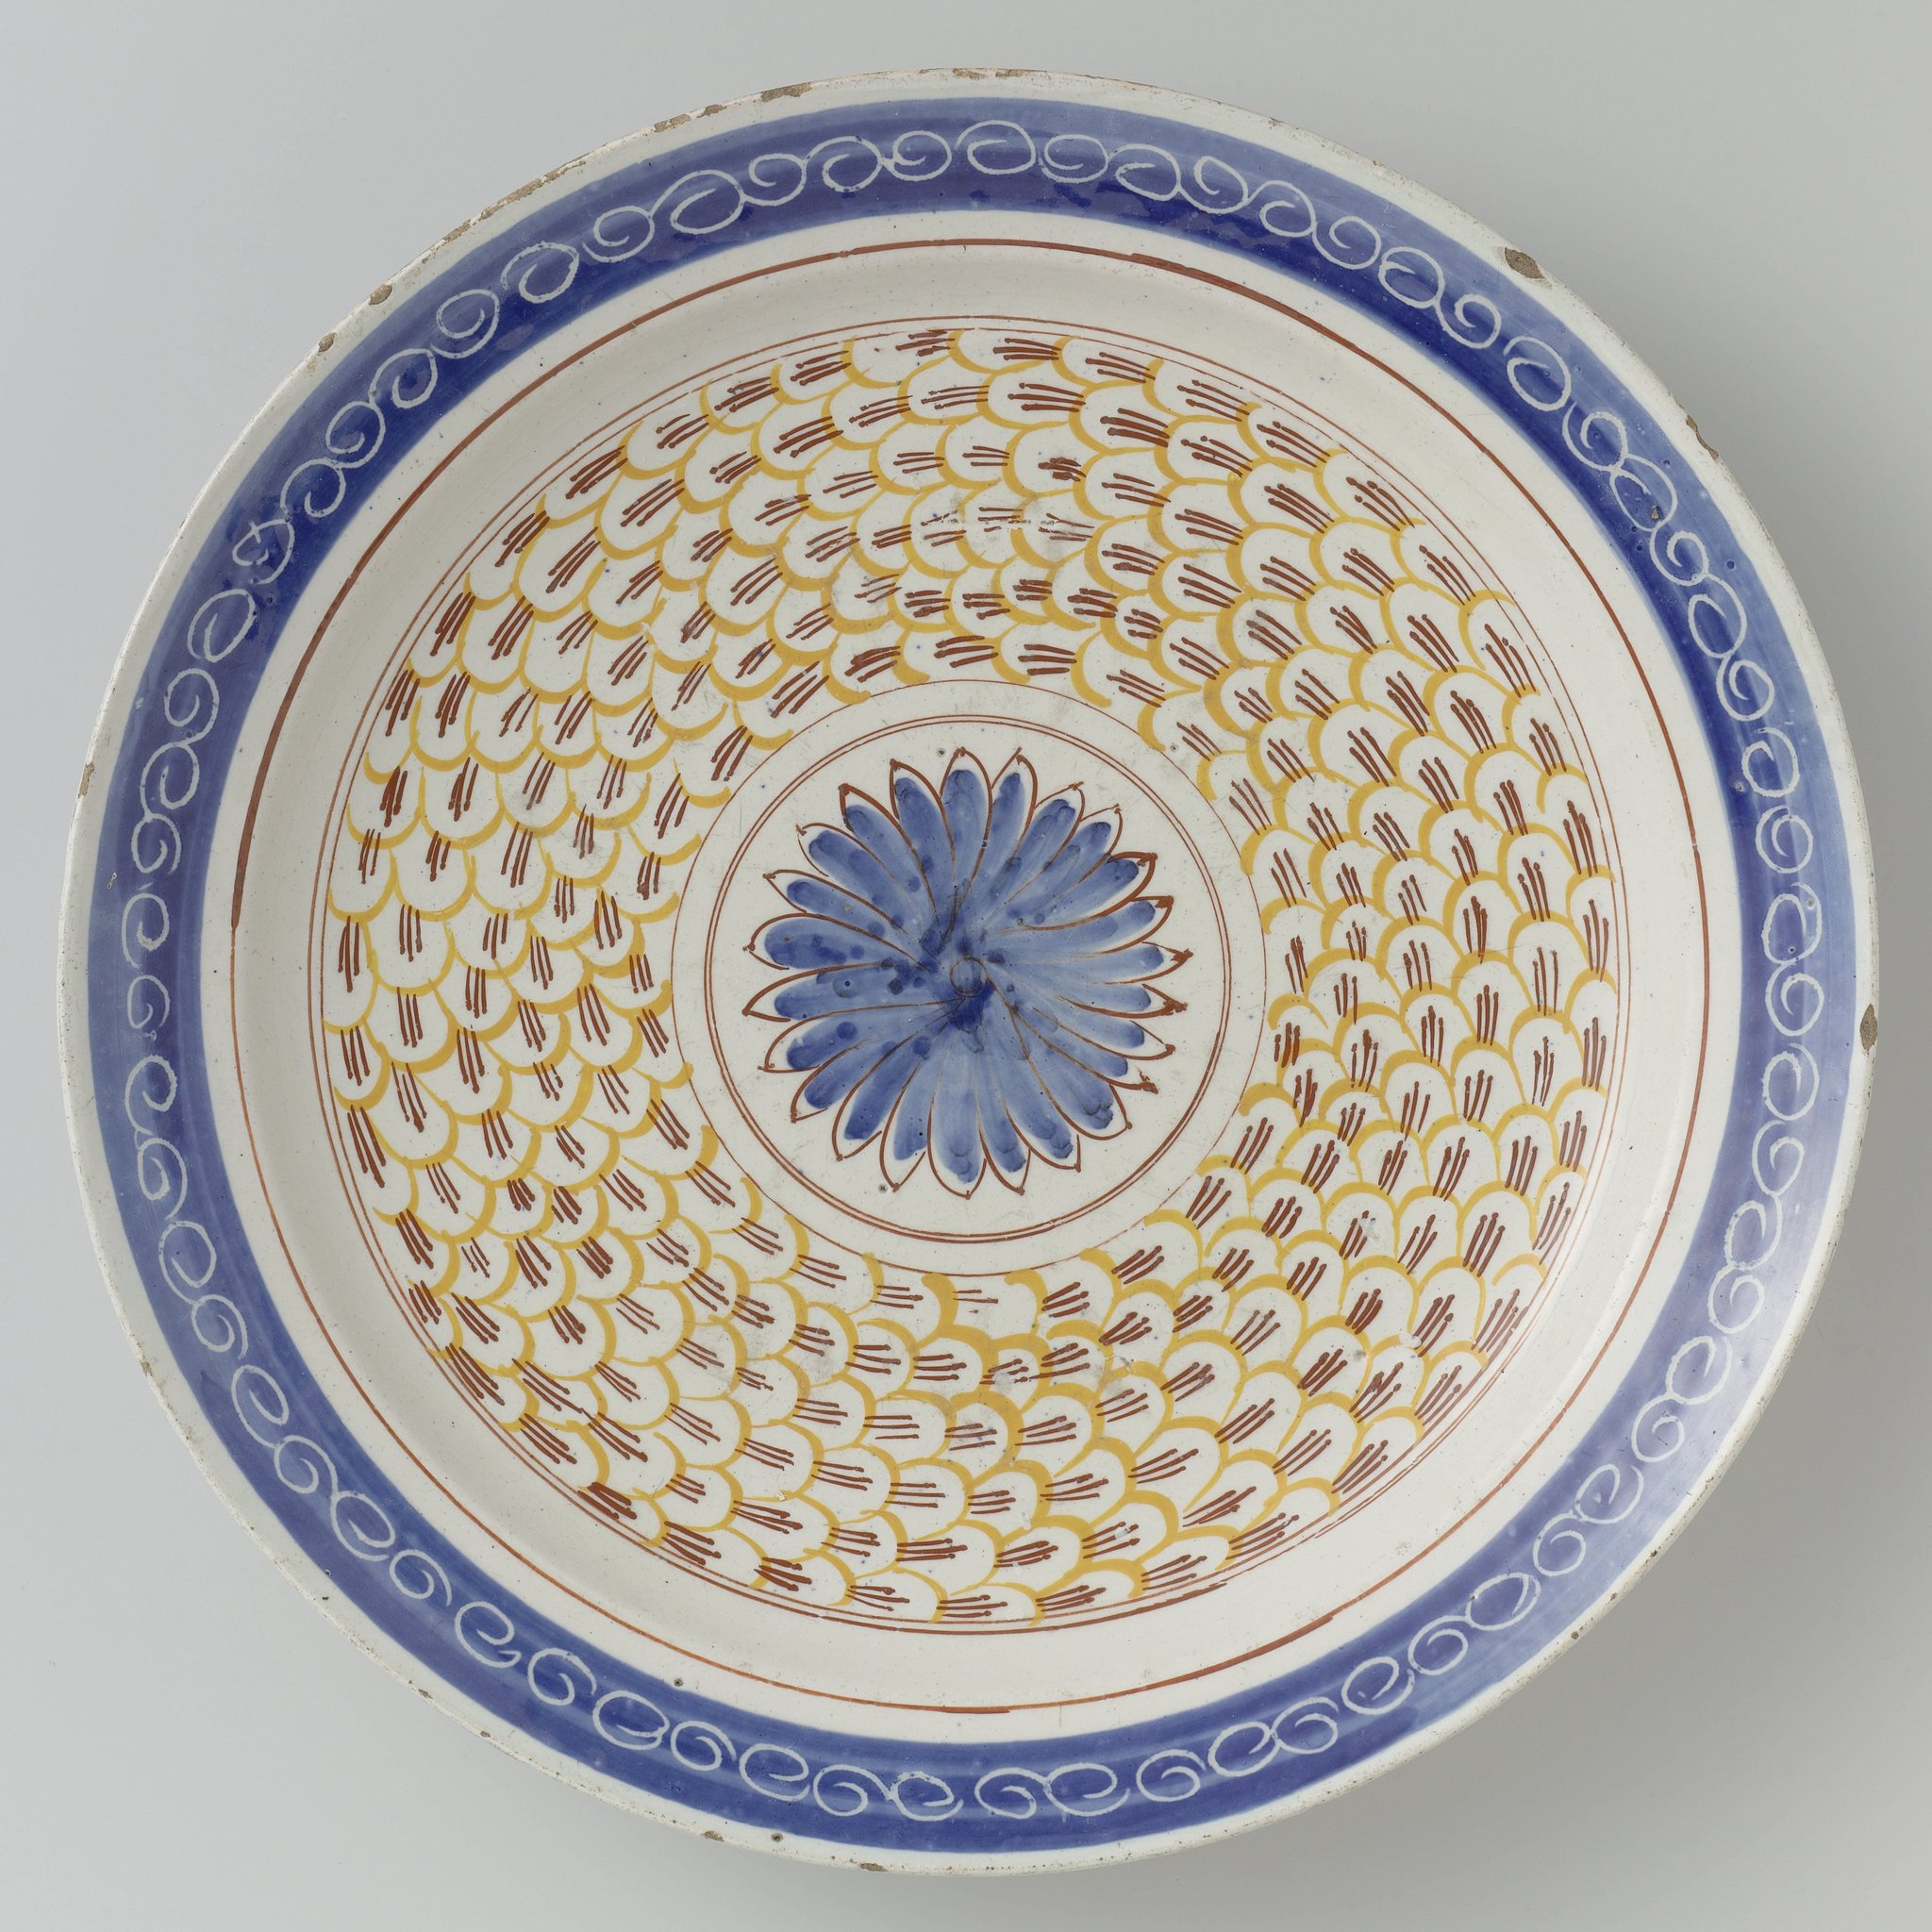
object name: platter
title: Schotel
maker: Anonymous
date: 1700-1740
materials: faience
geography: delft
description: Schotel van faience. Veelkleurig beschilderd.